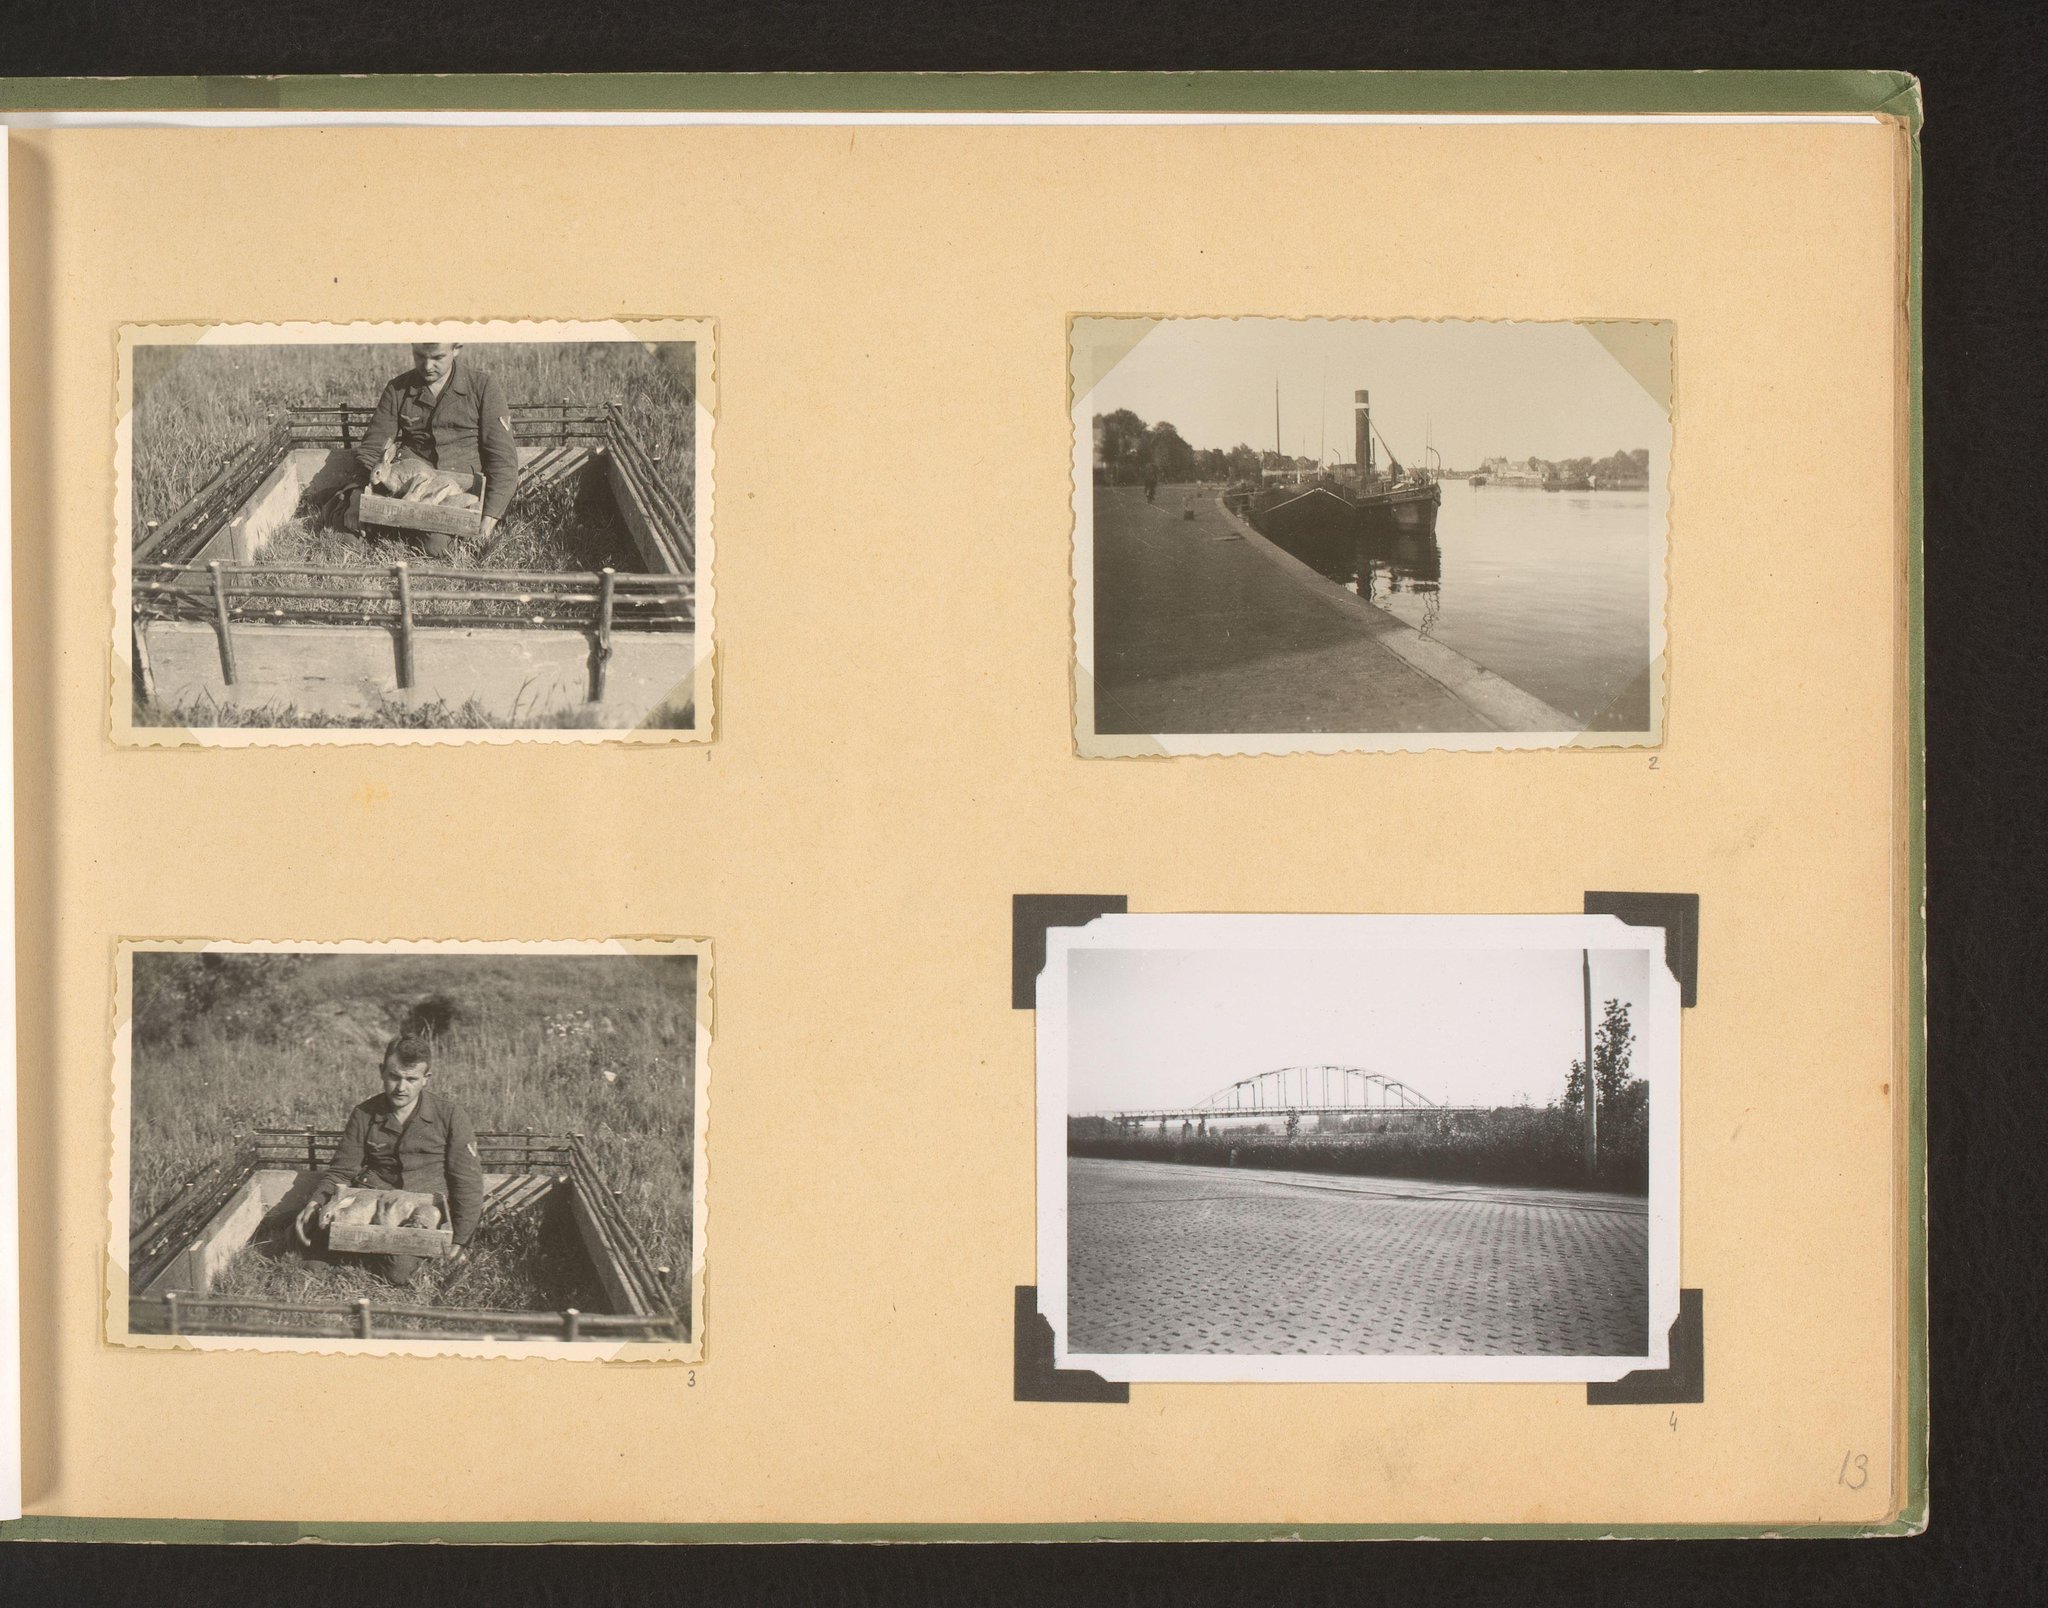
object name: photograph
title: Duitse militair met konijnen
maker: Anonymous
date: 1940-1944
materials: paper, photographic support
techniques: gelatin silver print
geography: netherlands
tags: the company, the unit, the troop ~ military service, recreation ~ the soldier off duty, bridge, quay, rodents: rabbit, netherlands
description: Albumblad met vier foto´s van een Duitse militair met konijnen in een hok en van een kade en een brug. Onderdeel van het fotoalbum Bewaking bunkers.